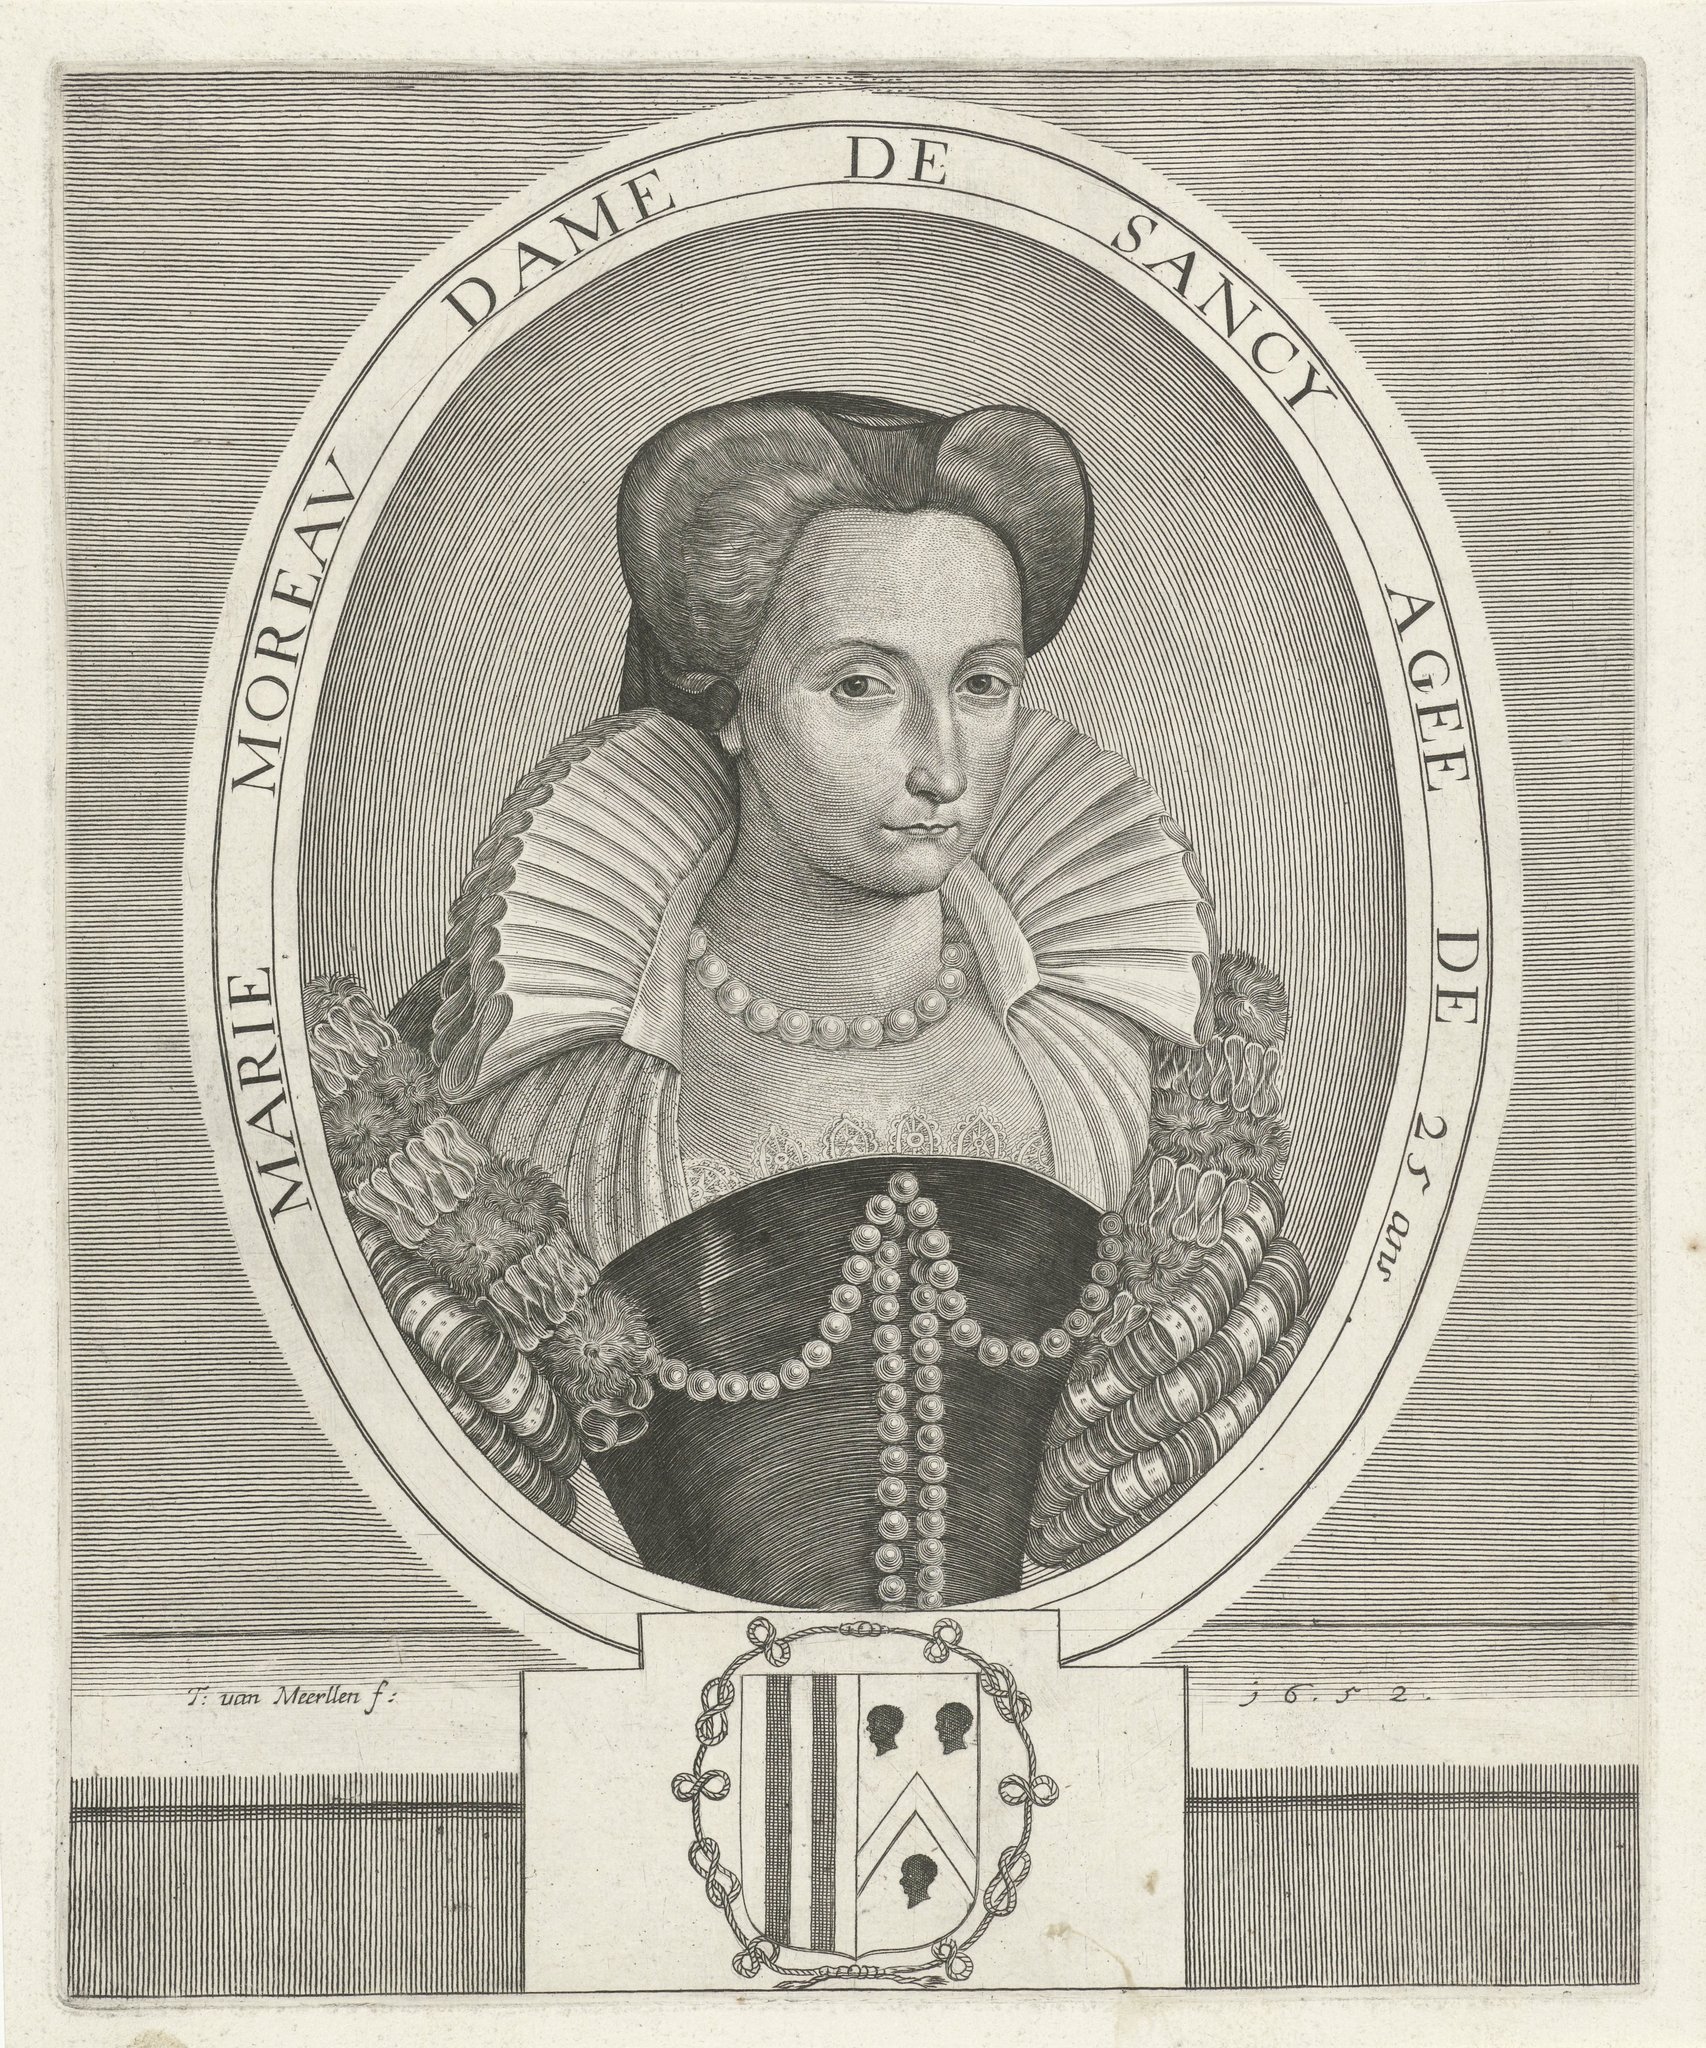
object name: print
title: Portret van Marie Moreau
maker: theodor van merlen (ii)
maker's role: print maker, publisher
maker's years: 1609-1672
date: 1652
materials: paper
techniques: engraving, etching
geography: antwerp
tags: marie moreau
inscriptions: collector's mark: Lugt 2228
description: Portret van Marie Moreau, de vrouw van Nicolas de Harlay de Sancy, op 25-jarige leeftijd. Midden onder haar wapenschild.